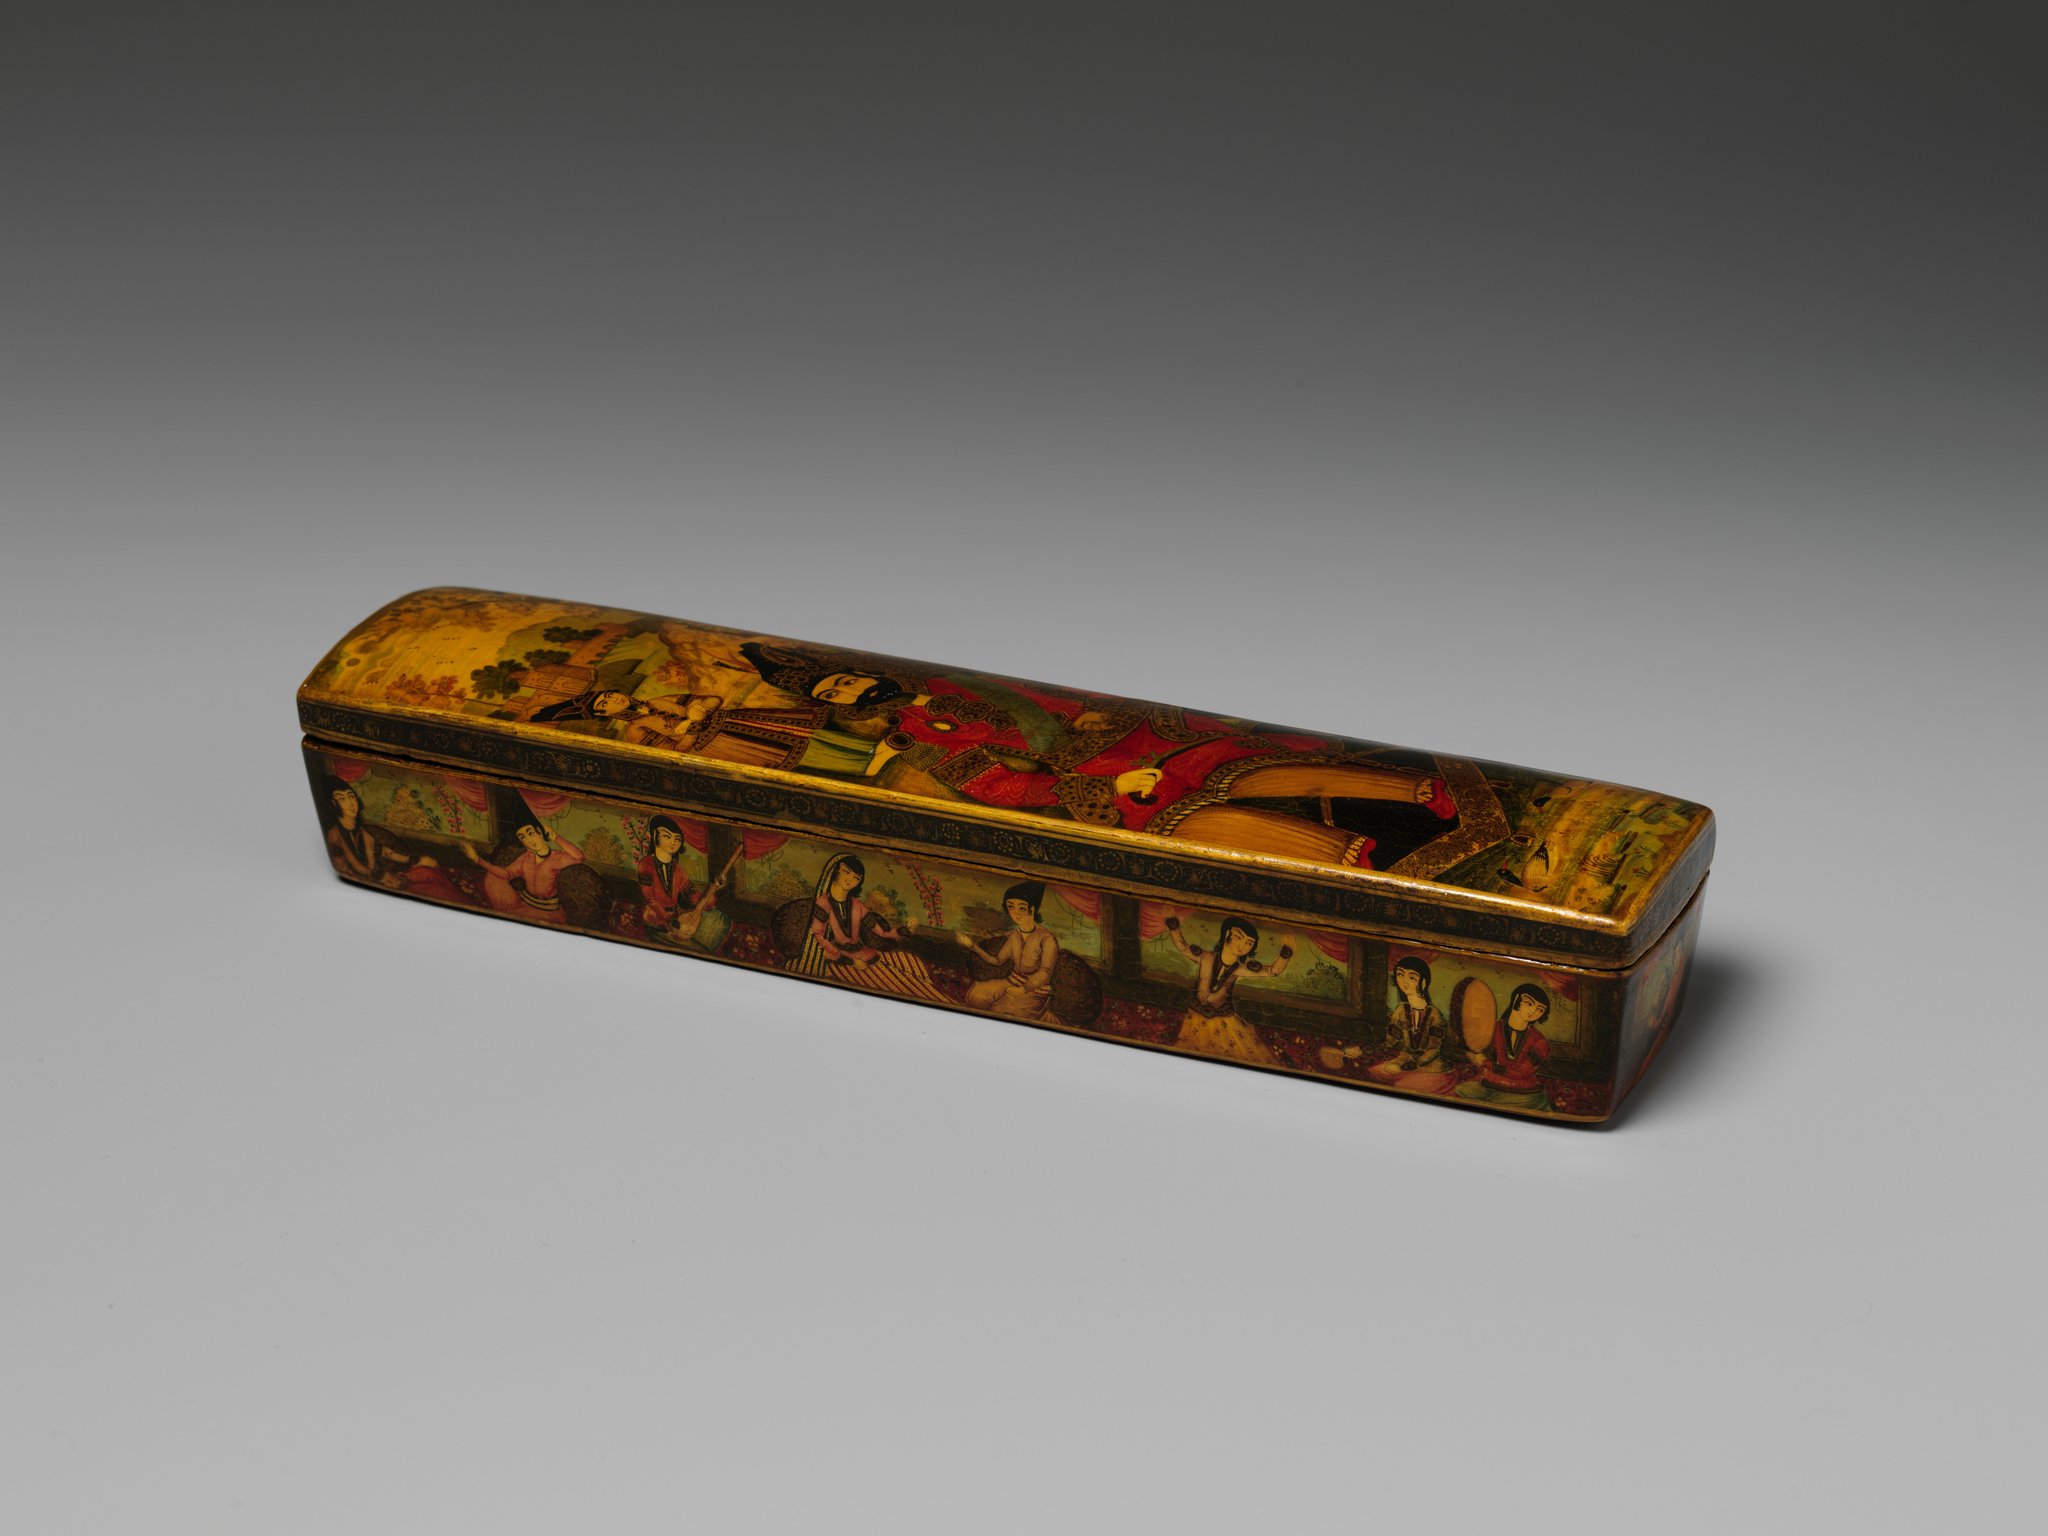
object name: penbox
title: Penbox with Portrait of Muhammad Shah Qajar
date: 1840-1849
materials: paper, varnish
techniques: painting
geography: iran